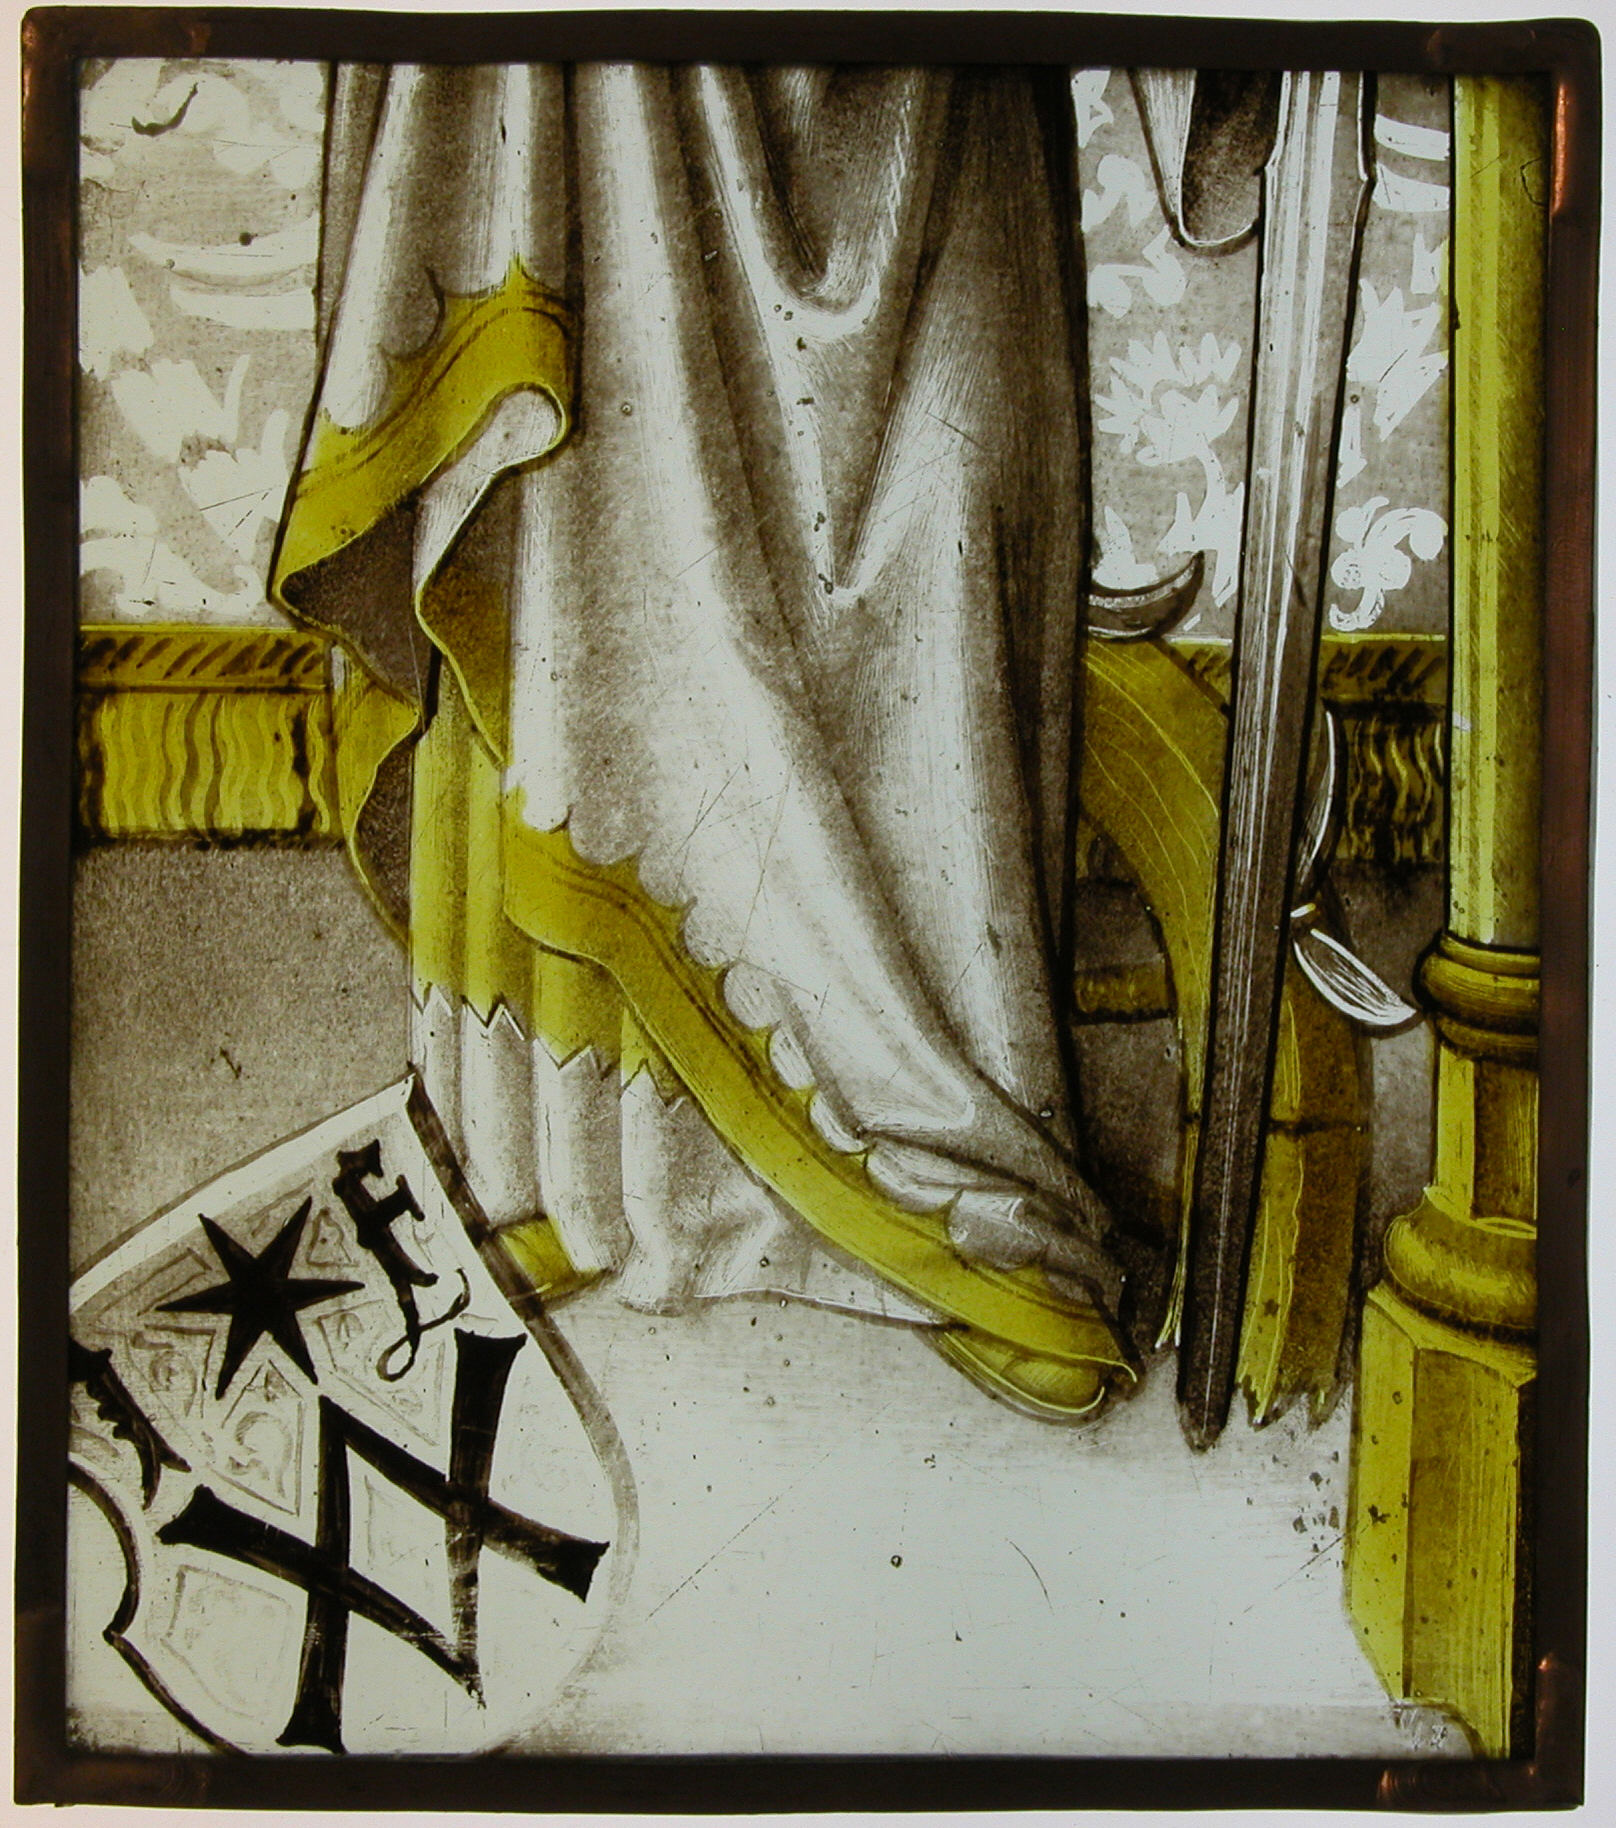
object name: fragment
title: Saint Catherine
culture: german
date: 1510-1515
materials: glass, paint, pigment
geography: germany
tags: coat of arms